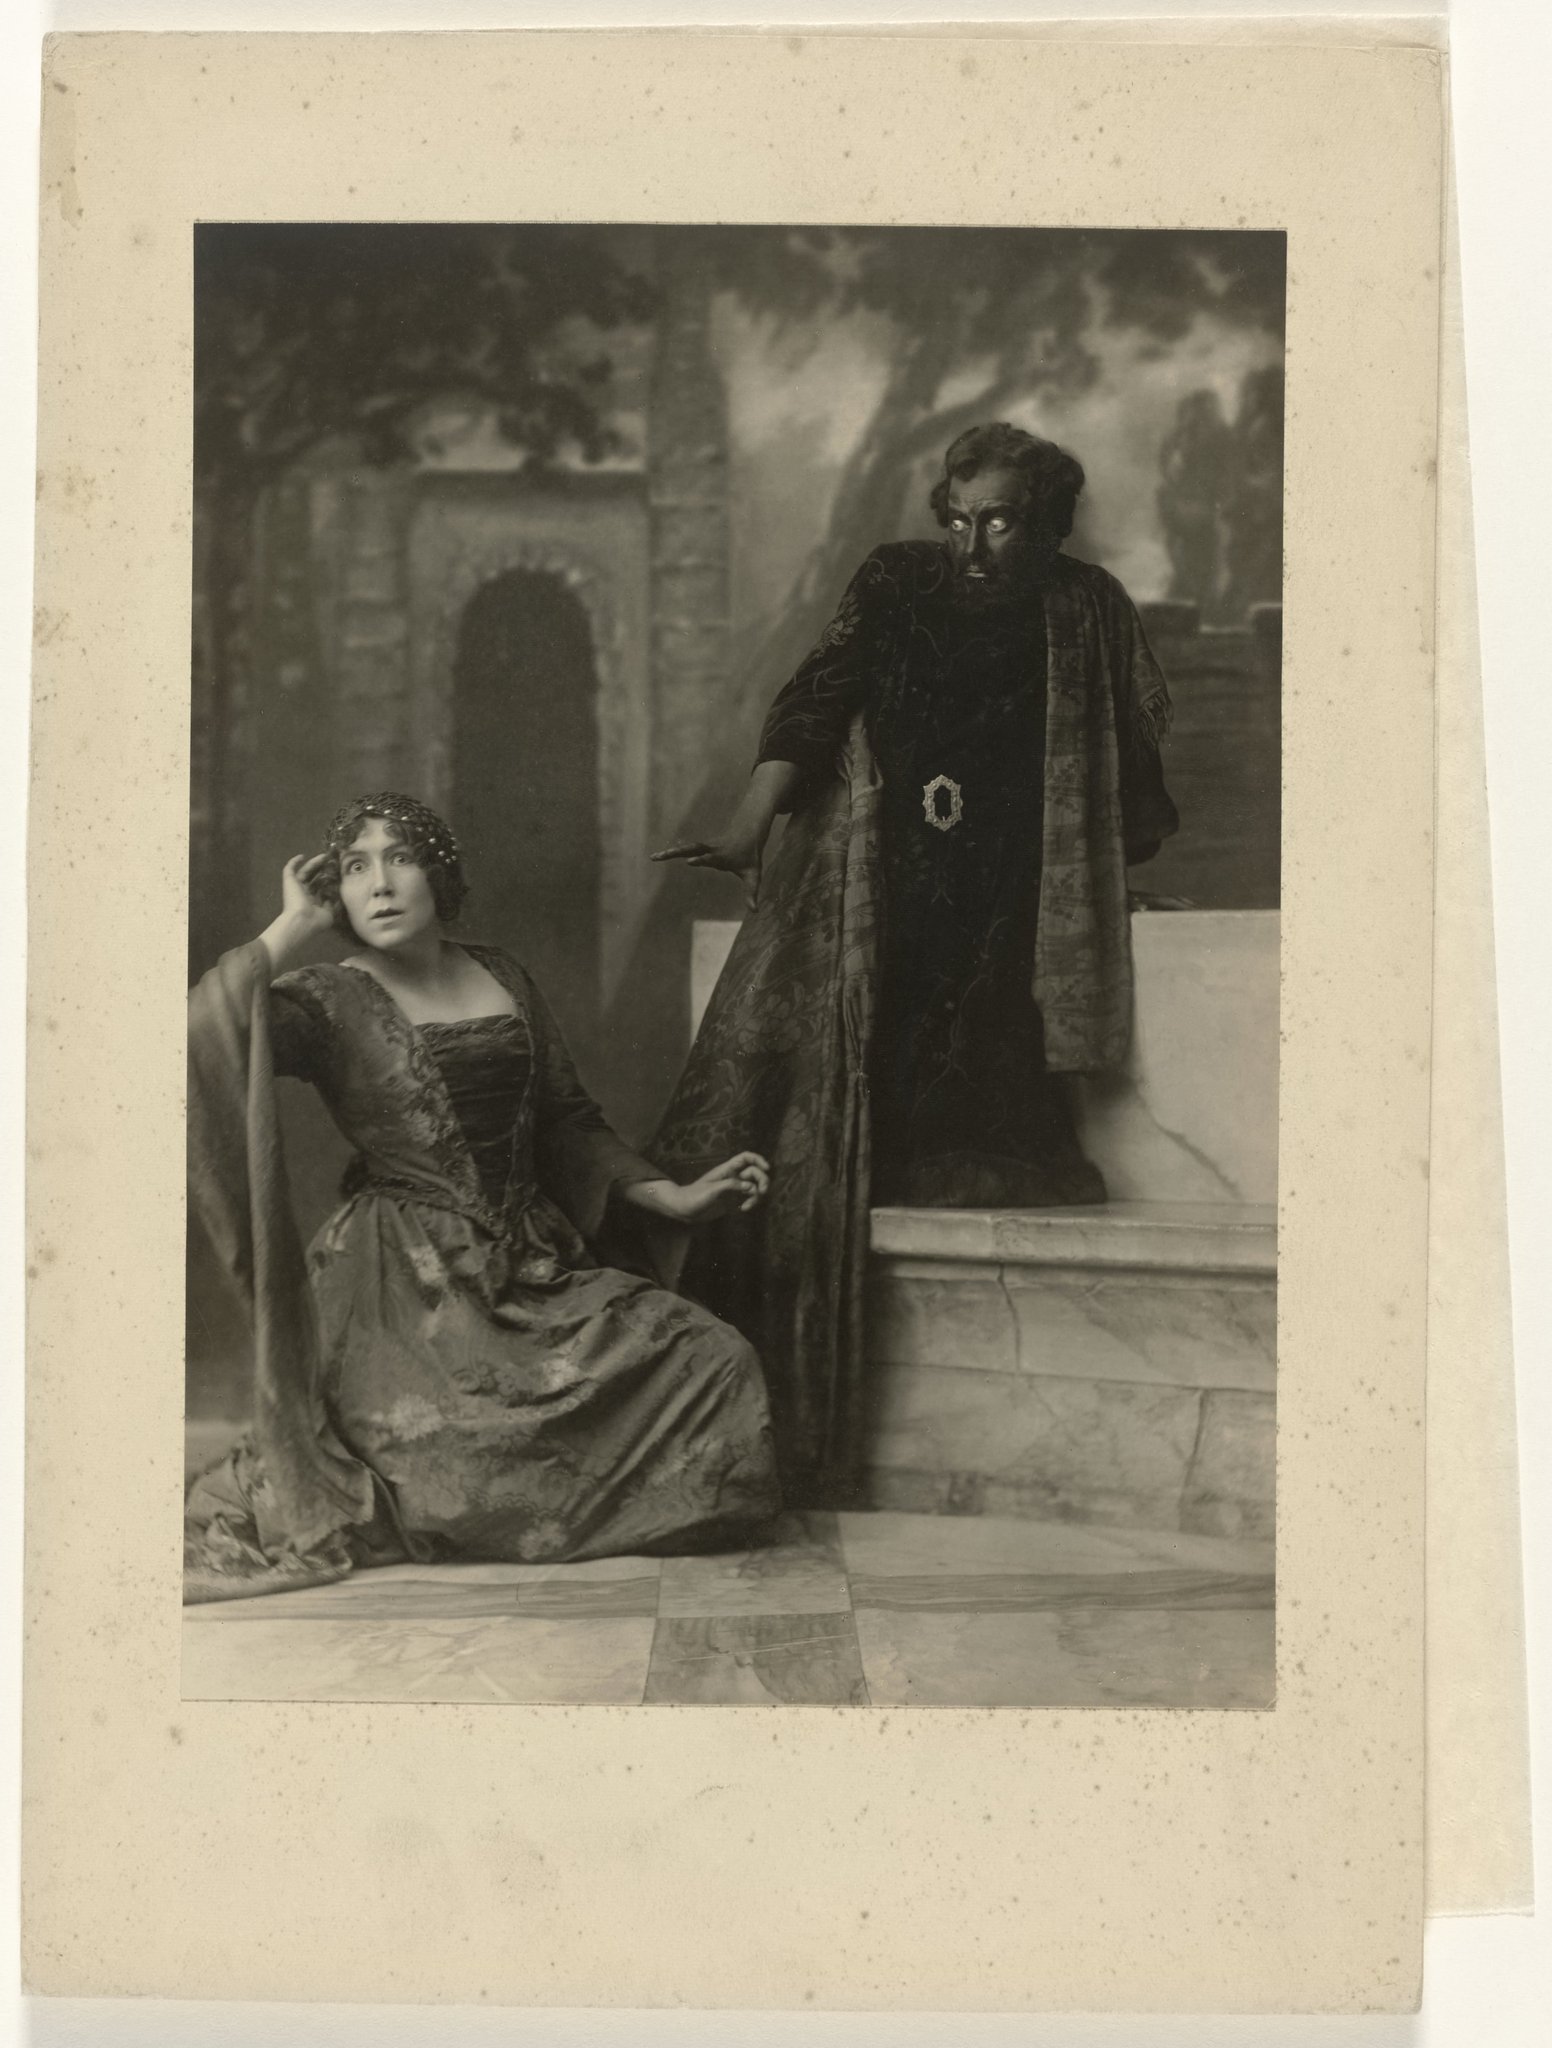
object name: photograph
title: Van Dalsum en Rie Gilhuys Sasbach in toneelstuk Othello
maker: jacob merkelbach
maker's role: fotograaf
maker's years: 1877-1942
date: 1920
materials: paper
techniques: gelatin silver print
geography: amsterdam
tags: portrait of actor, actress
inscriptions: inscription: ‘Van Dalsum en Rie Gilhuys Sasbach in Othello’